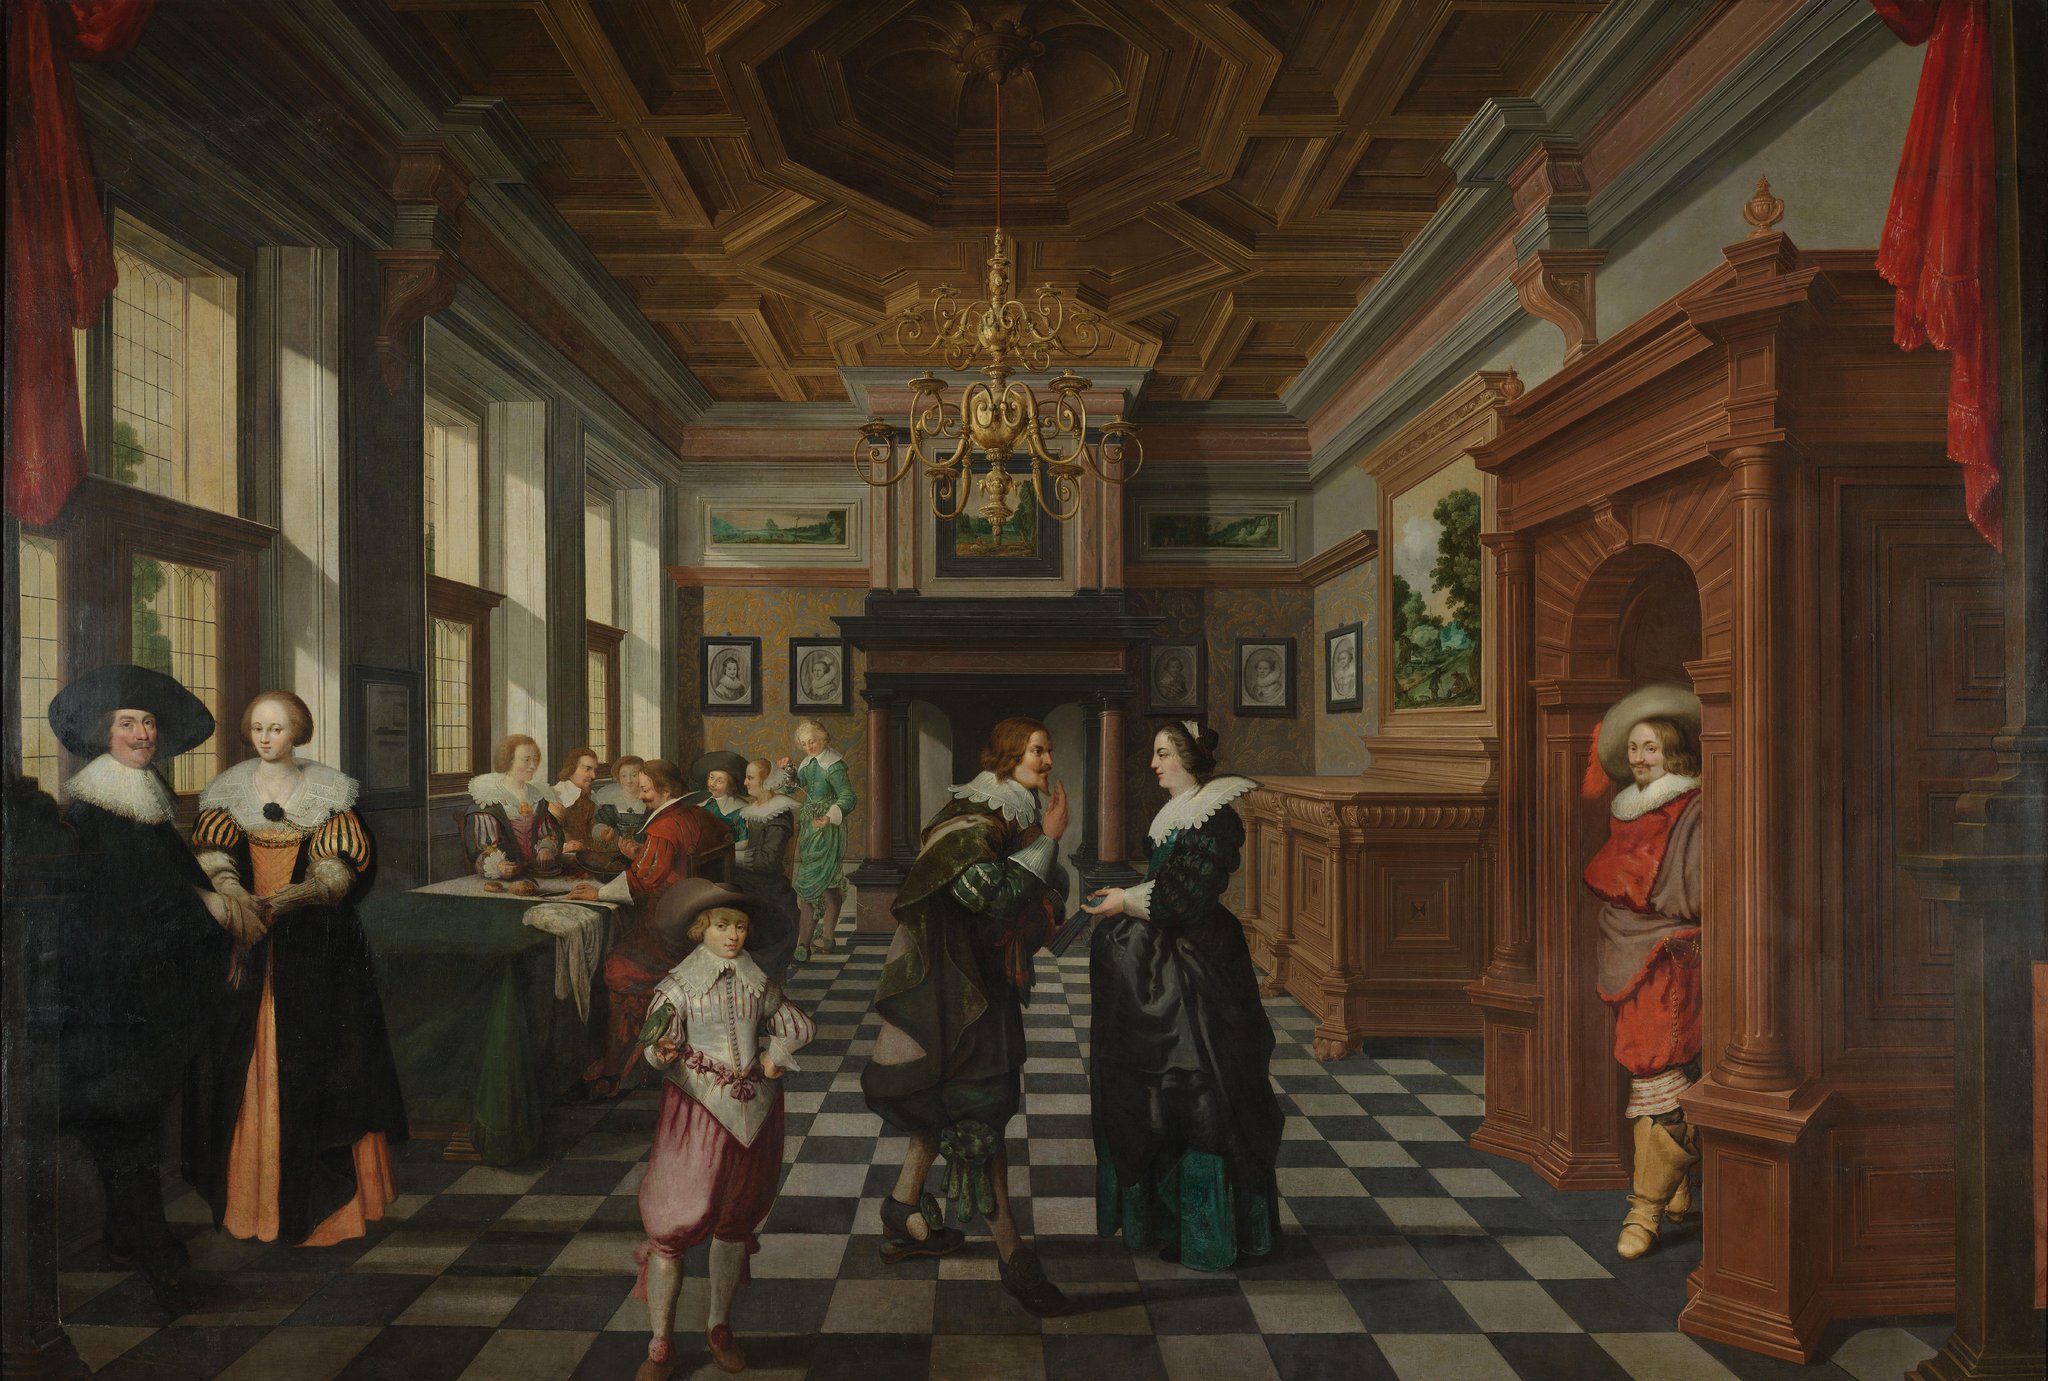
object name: wall decoration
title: A Seven-Part Decorative Sequence: An Interior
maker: dirck van delen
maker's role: painter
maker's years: 1604-1671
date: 1630-1632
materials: canvas, oil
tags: historical persons - bb - woman, historical persons, communal rooms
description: Onderdeel van een zevendelige kamerbeschildering in vijf stukken met afbeeldingen van een interieur, twee galerijen en twee buitentrappen, bevolkt met talrijke personen. Dit stuk toont een interieur met verschillende personen en schilderijen en portretten aan de muur. Rechts komt een heer de kamer binnen. Onder de aanwezigen Elisabeth van de Palts en Lord Craven.